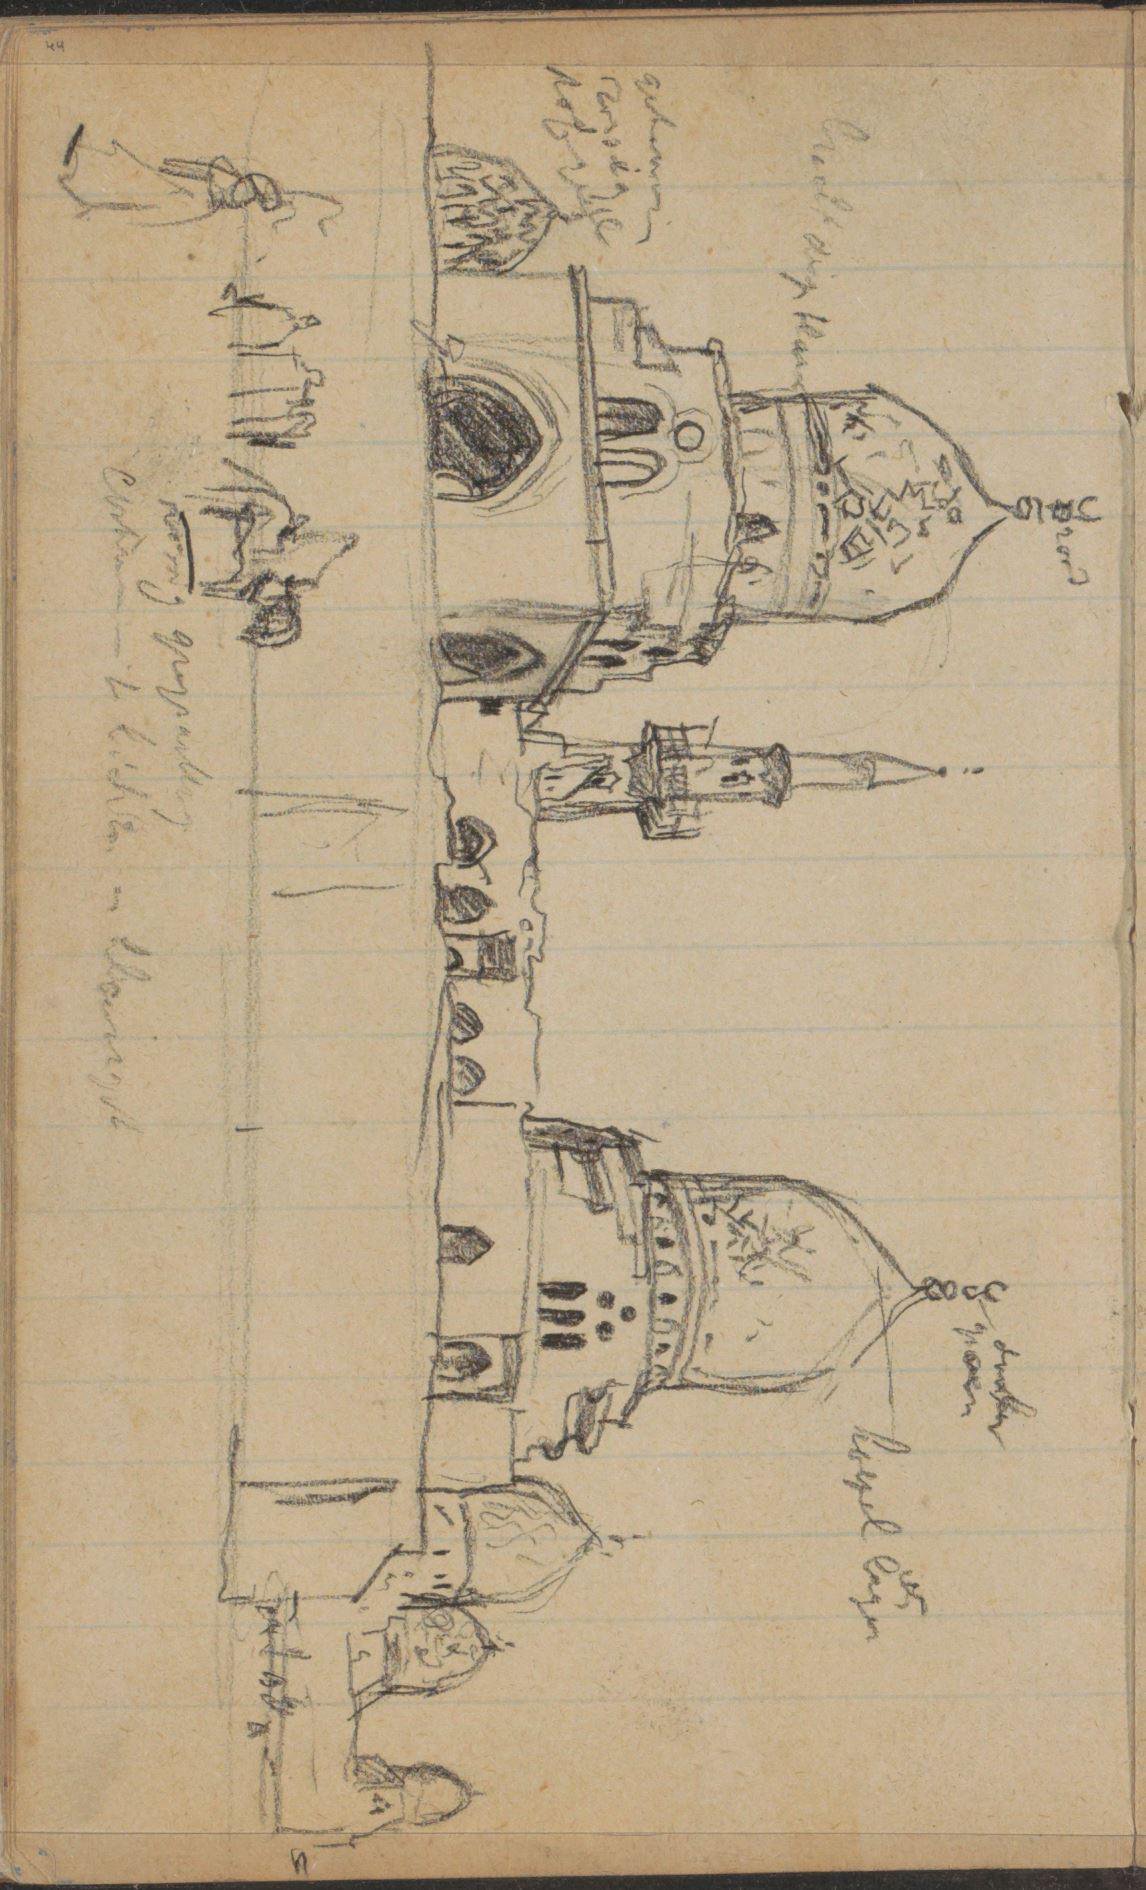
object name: sketchbook leaf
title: Graven van de Kaliefen in Caïro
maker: marius bauer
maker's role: draughtsman, print maker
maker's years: 1867-1932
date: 1894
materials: chalk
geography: cairo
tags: grave-building, monumental tomb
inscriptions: kleurnotitie, handgeschreven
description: Pagina 44 uit een schetsboek met 48 bladen.